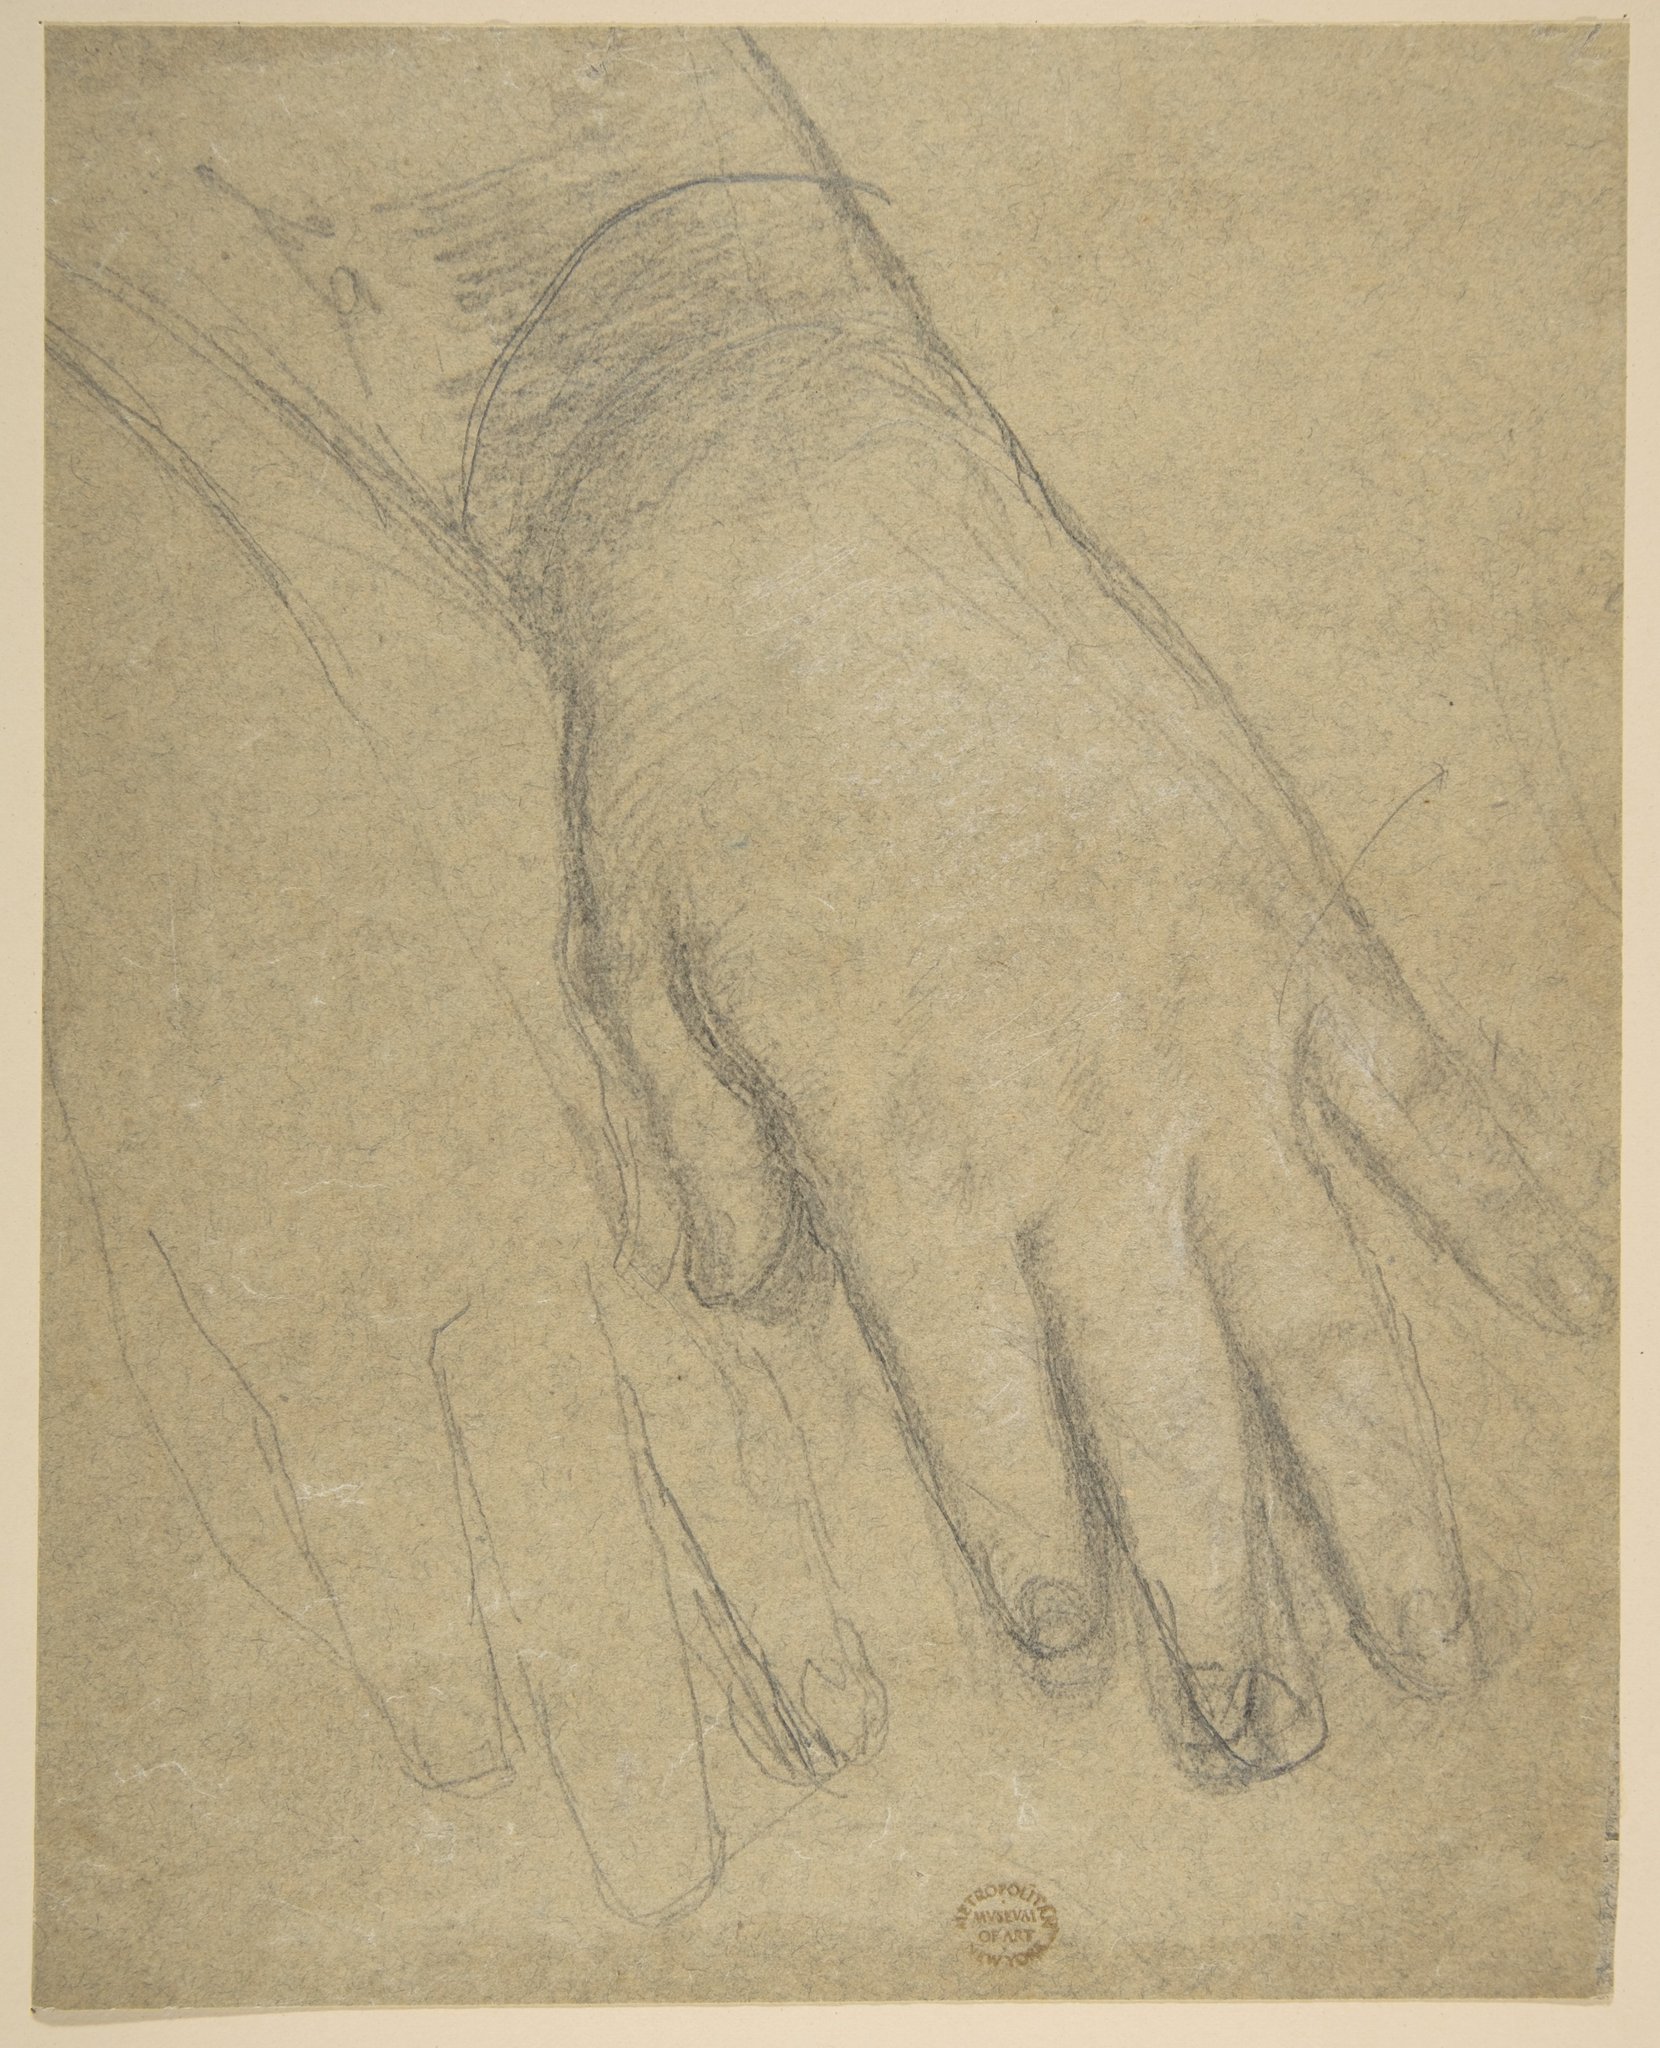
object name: drawing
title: Study of a Hand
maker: anonymous, french, 19th century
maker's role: artist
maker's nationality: french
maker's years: 1800-1900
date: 1801-1900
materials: graphite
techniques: heightening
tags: hands